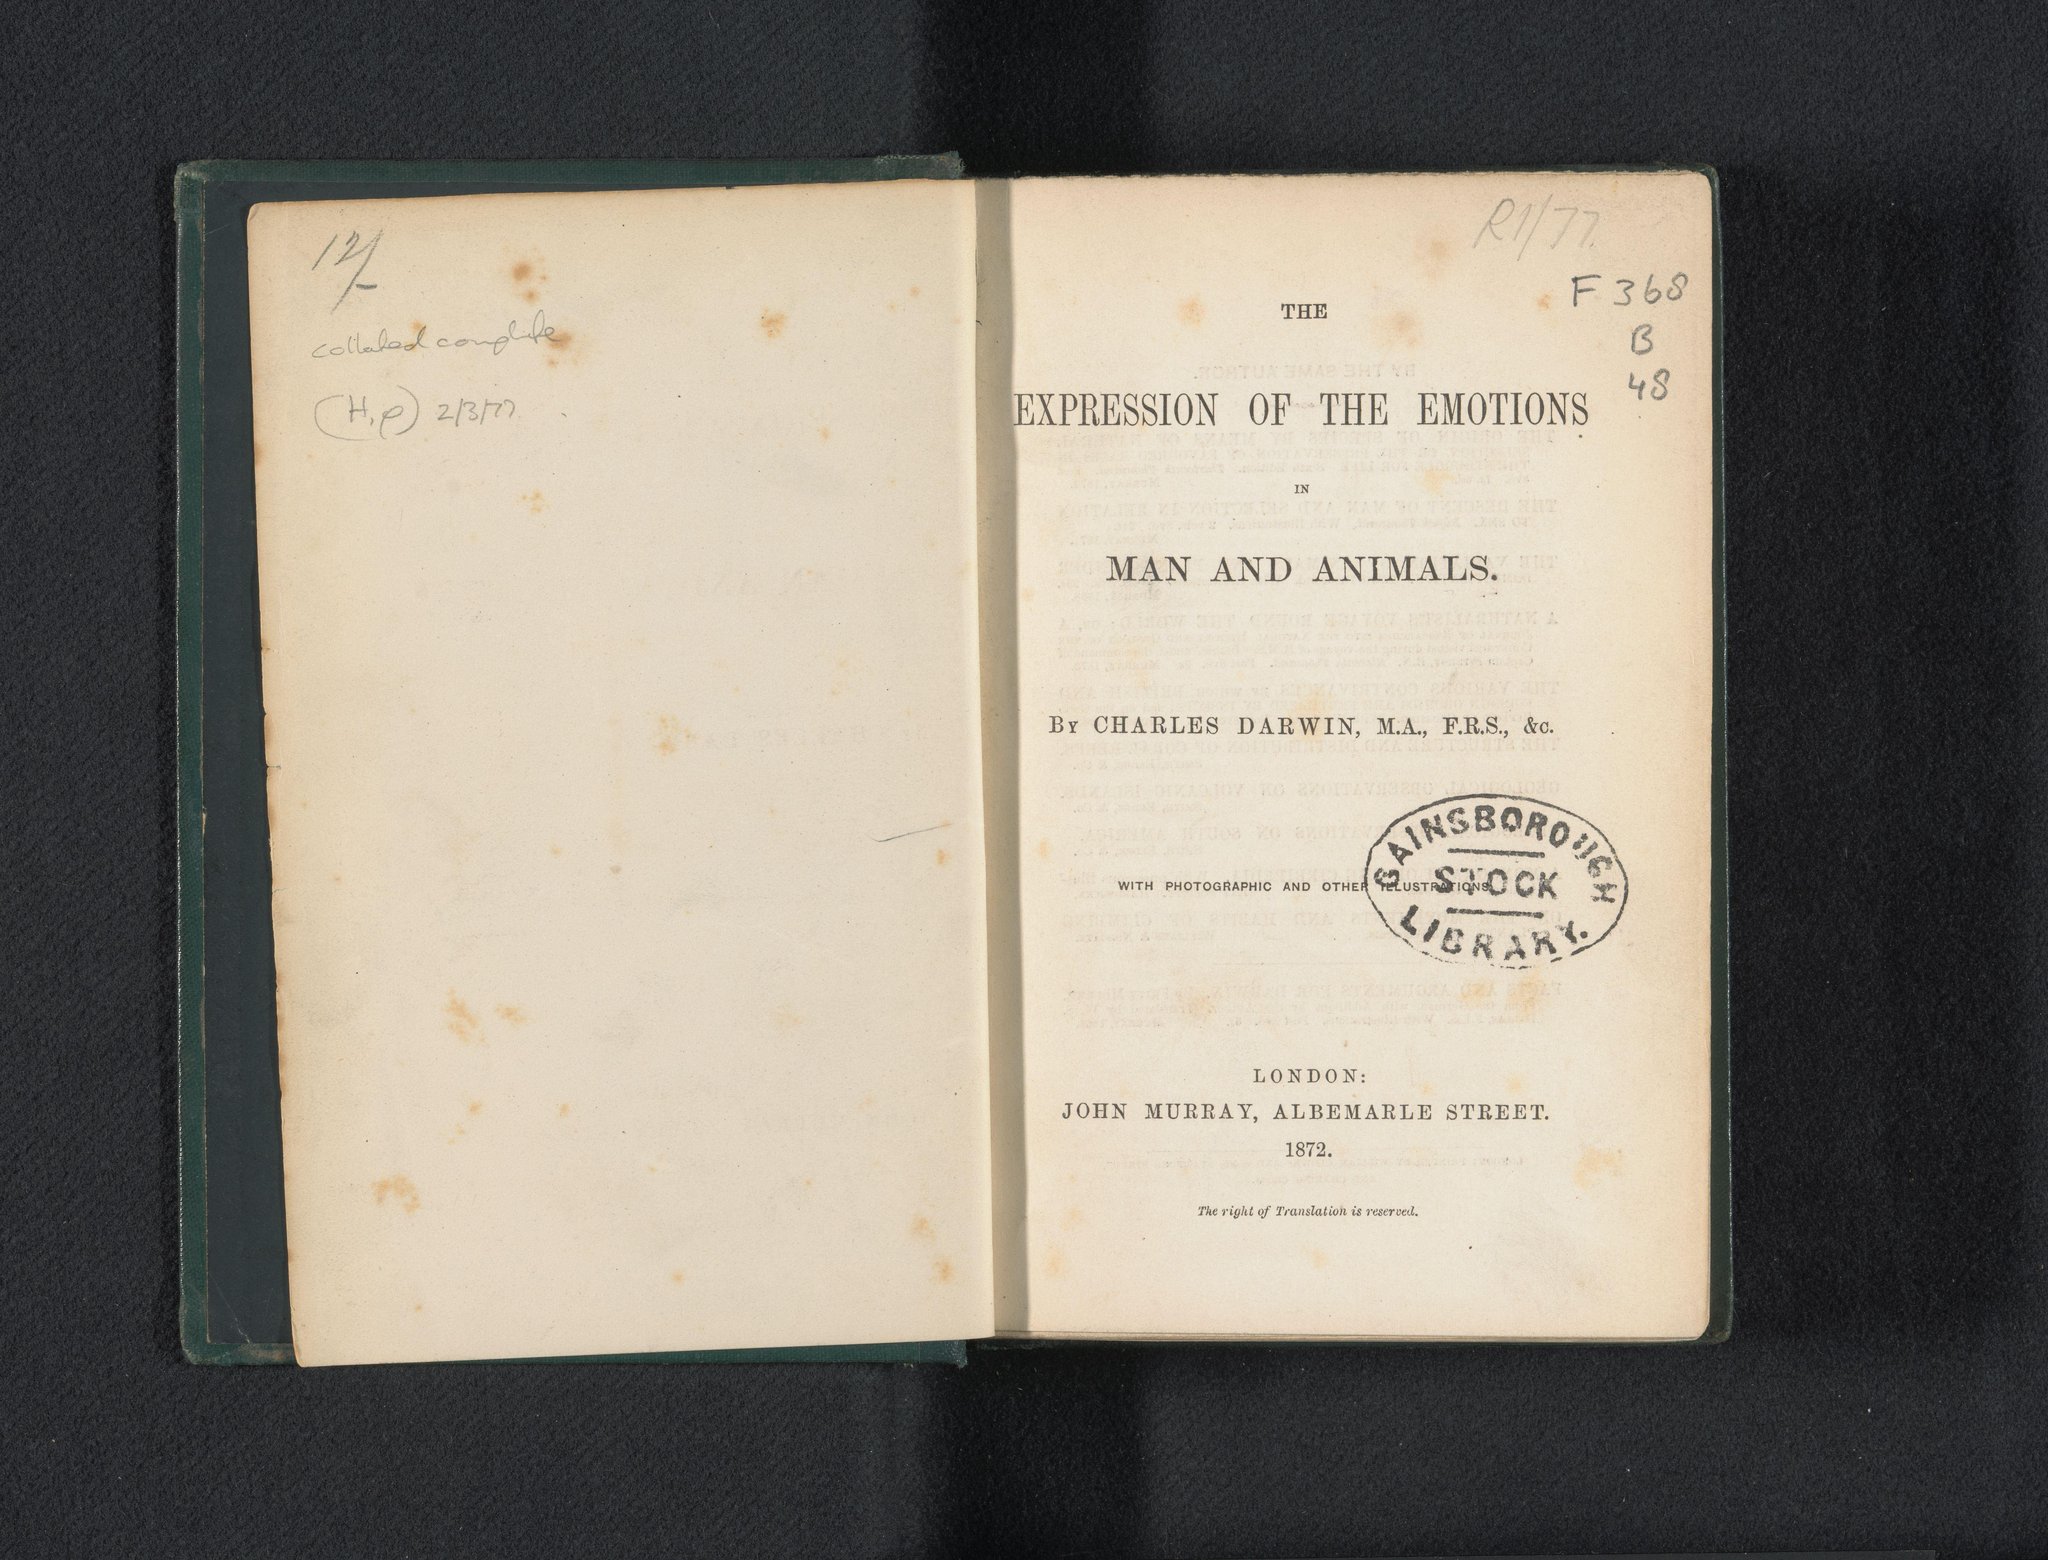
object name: book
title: The expression of the emotions in man and animals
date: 1872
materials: cardboard, paper, textile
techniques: photoaquatint, printing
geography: london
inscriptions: bookplate: ‘SFJ Ex Libirs’, annotation: ‘MAY 1981’